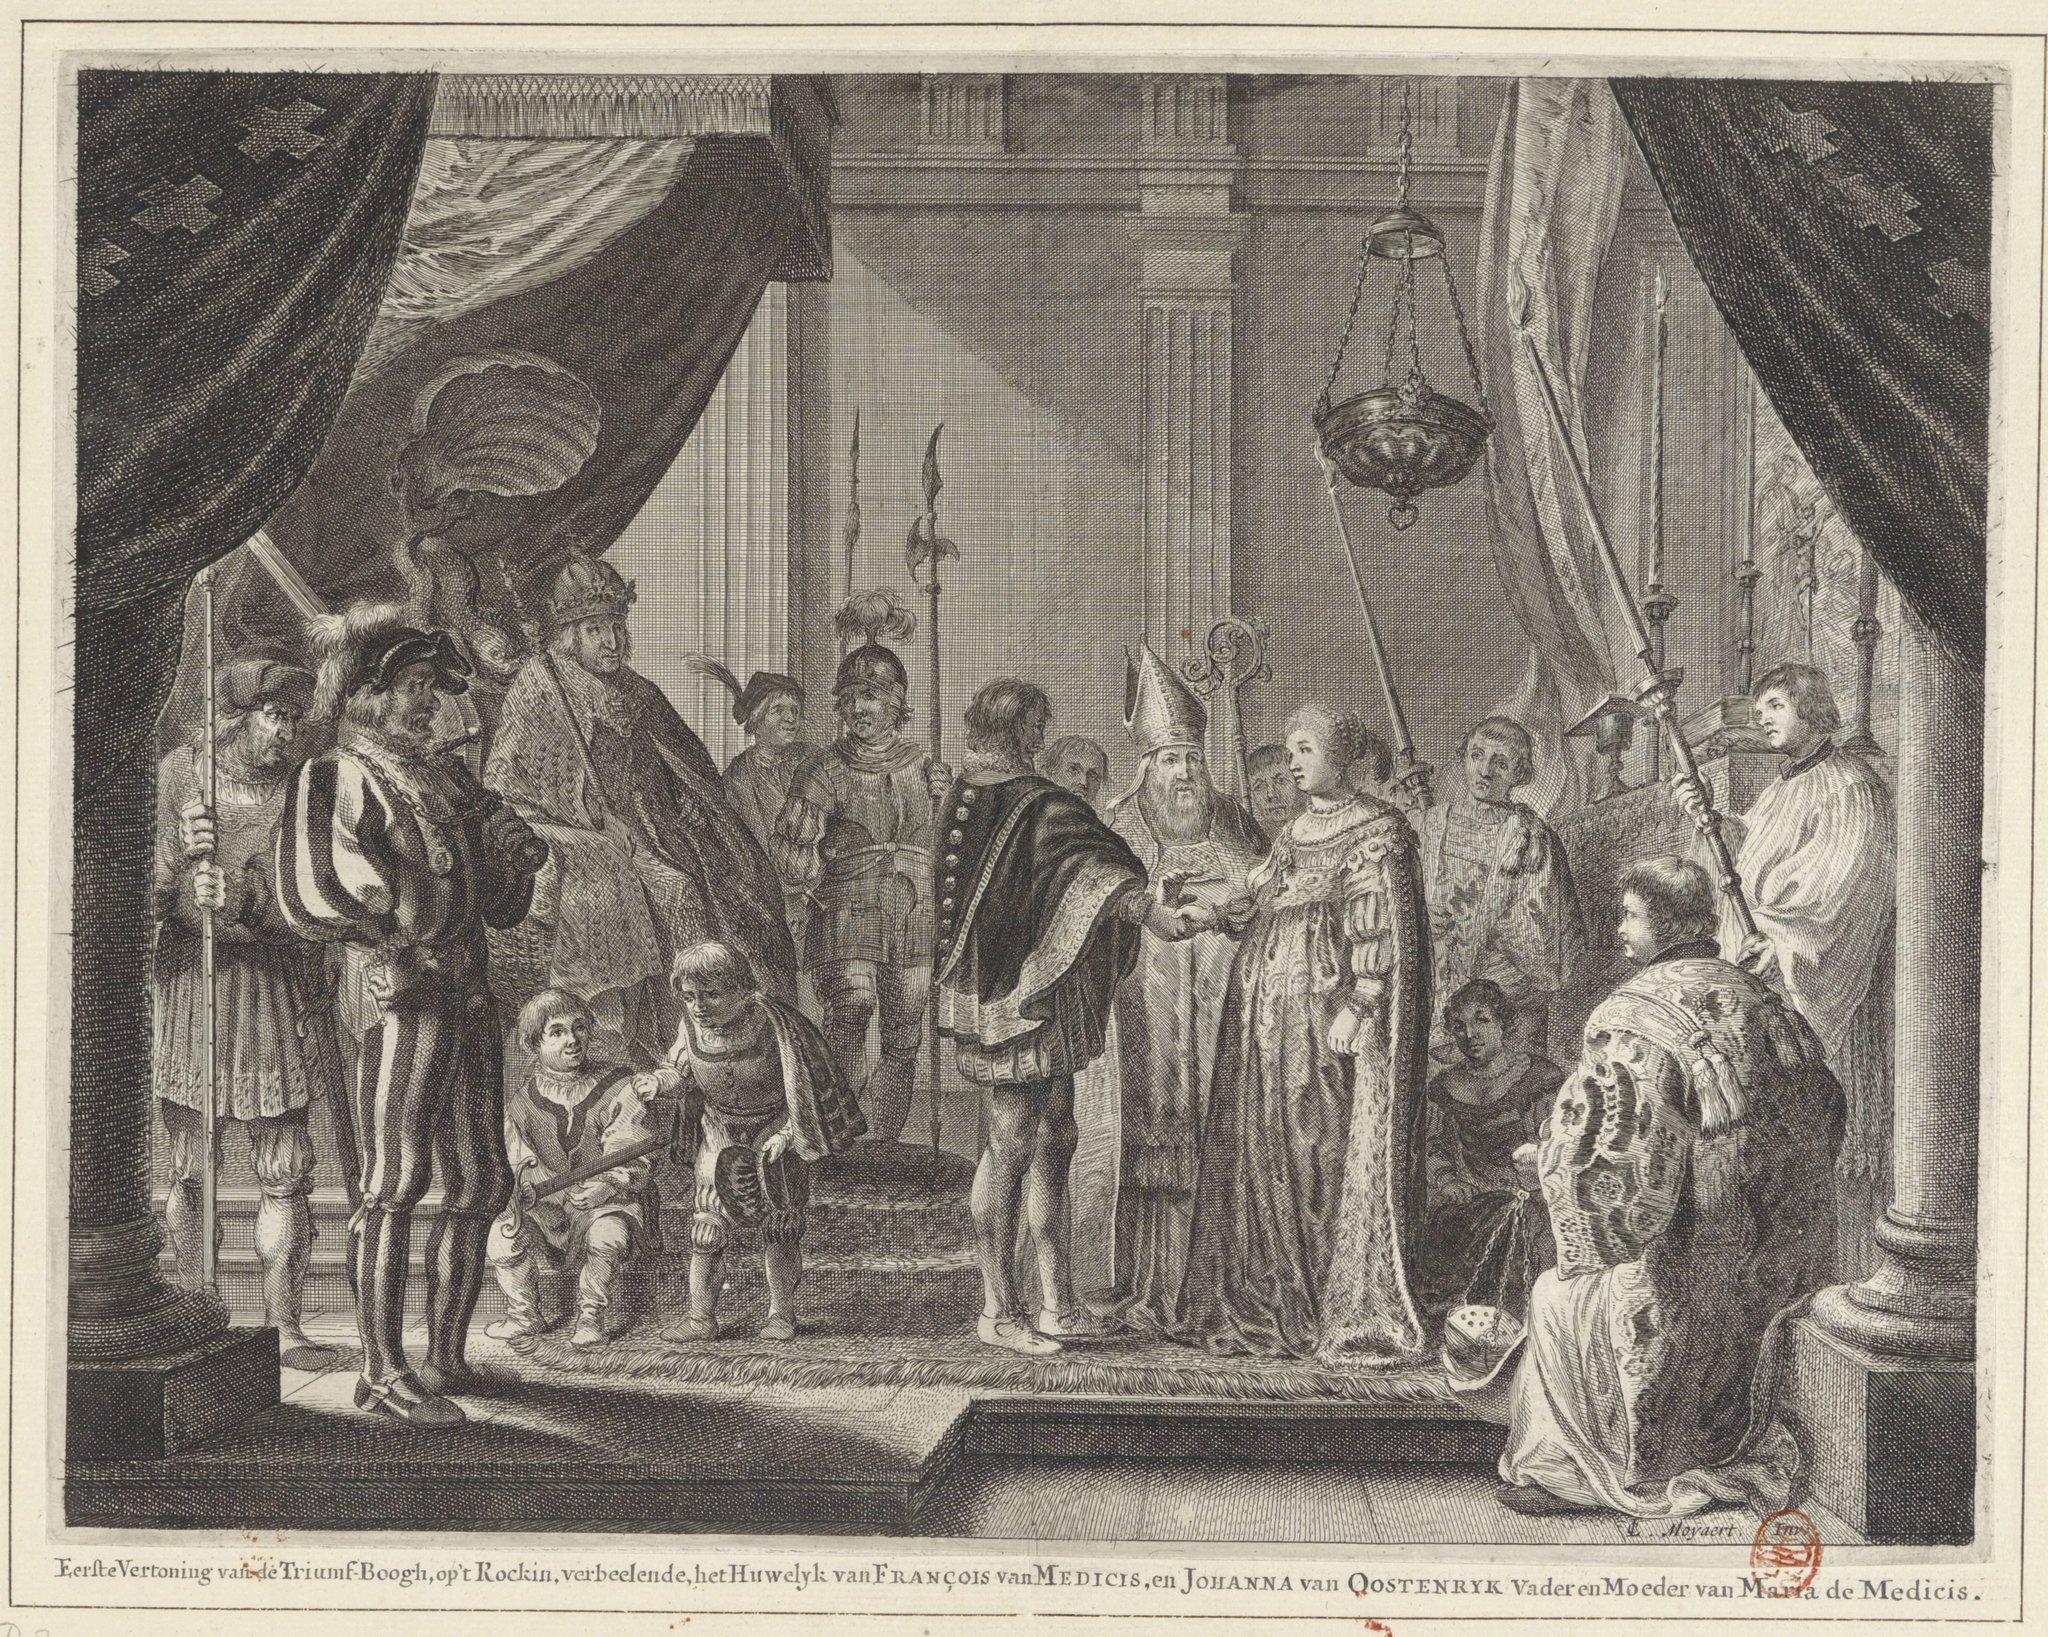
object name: print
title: Feestelijkheden bij het bezoek van Maria de' Medici aan Amsterdam in 1638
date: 1638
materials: paper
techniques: engraving, etching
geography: amsterdam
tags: francesco i de' medici, cologne, maria de' medici, ferdinand i van habsburg (duits keizer), 'tableau vivant', triumphal entry and public reception, pageant, 'entrée solennelle', 'joyeuse entrée', blessing the married couple, (civil) marriage ceremonies, amsterdam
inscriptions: inscription: ‘Eerste Vertoning van de Triumf-Boogh, op 't Rockin, verbeelende, het Huwelyk van François van Medicis, en Johanna van Oostenryk Vader en Moeder van Maria de Medicis’, collector's mark: Lugt 2228, collector's mark: Lugt 195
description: Prent ook gebruikt in:* Baerle, Caspar van. Medicea hospes, sive descriptio publicae gratulationis, qua Serenissimam, Augustissimamque Reginam, Mariam de Medicis (…). Amsterdam: Johannes en Cornelis Willemsz. Blaeu, 1638. En in: Baerle, Caspar van. Marie de Medicis, entrant dans Amsterdam : ou, histoire de la reception faicte à la Reyne Mere du Roy tres-Chrestien (…). Amsterdam: Johannes en Cornelis Willemsz. Blaeu, 1638. En in: Baerle, Caspar van en Joost van den Vondel. Blyde inkomst der allerdoorluchtighste koninginne, Maria de Medicis t' Amsterdam. Vertaelt uit het Latijn (…). Amsterdam: Johannes en Cornelis Willemsz. Blaeu, 1639. * Doorgaans zijn de prenten in de bovengenoemde publicaties rechtsonder genummerd (van de huidige prent is dat de derde bekende staat). Maar er zijn ook exemplaren waarin eerdere, ongenummerde, staten van de prenten (van de huidige prent de eerste en tweede bekende staat) zijn ingebonden.